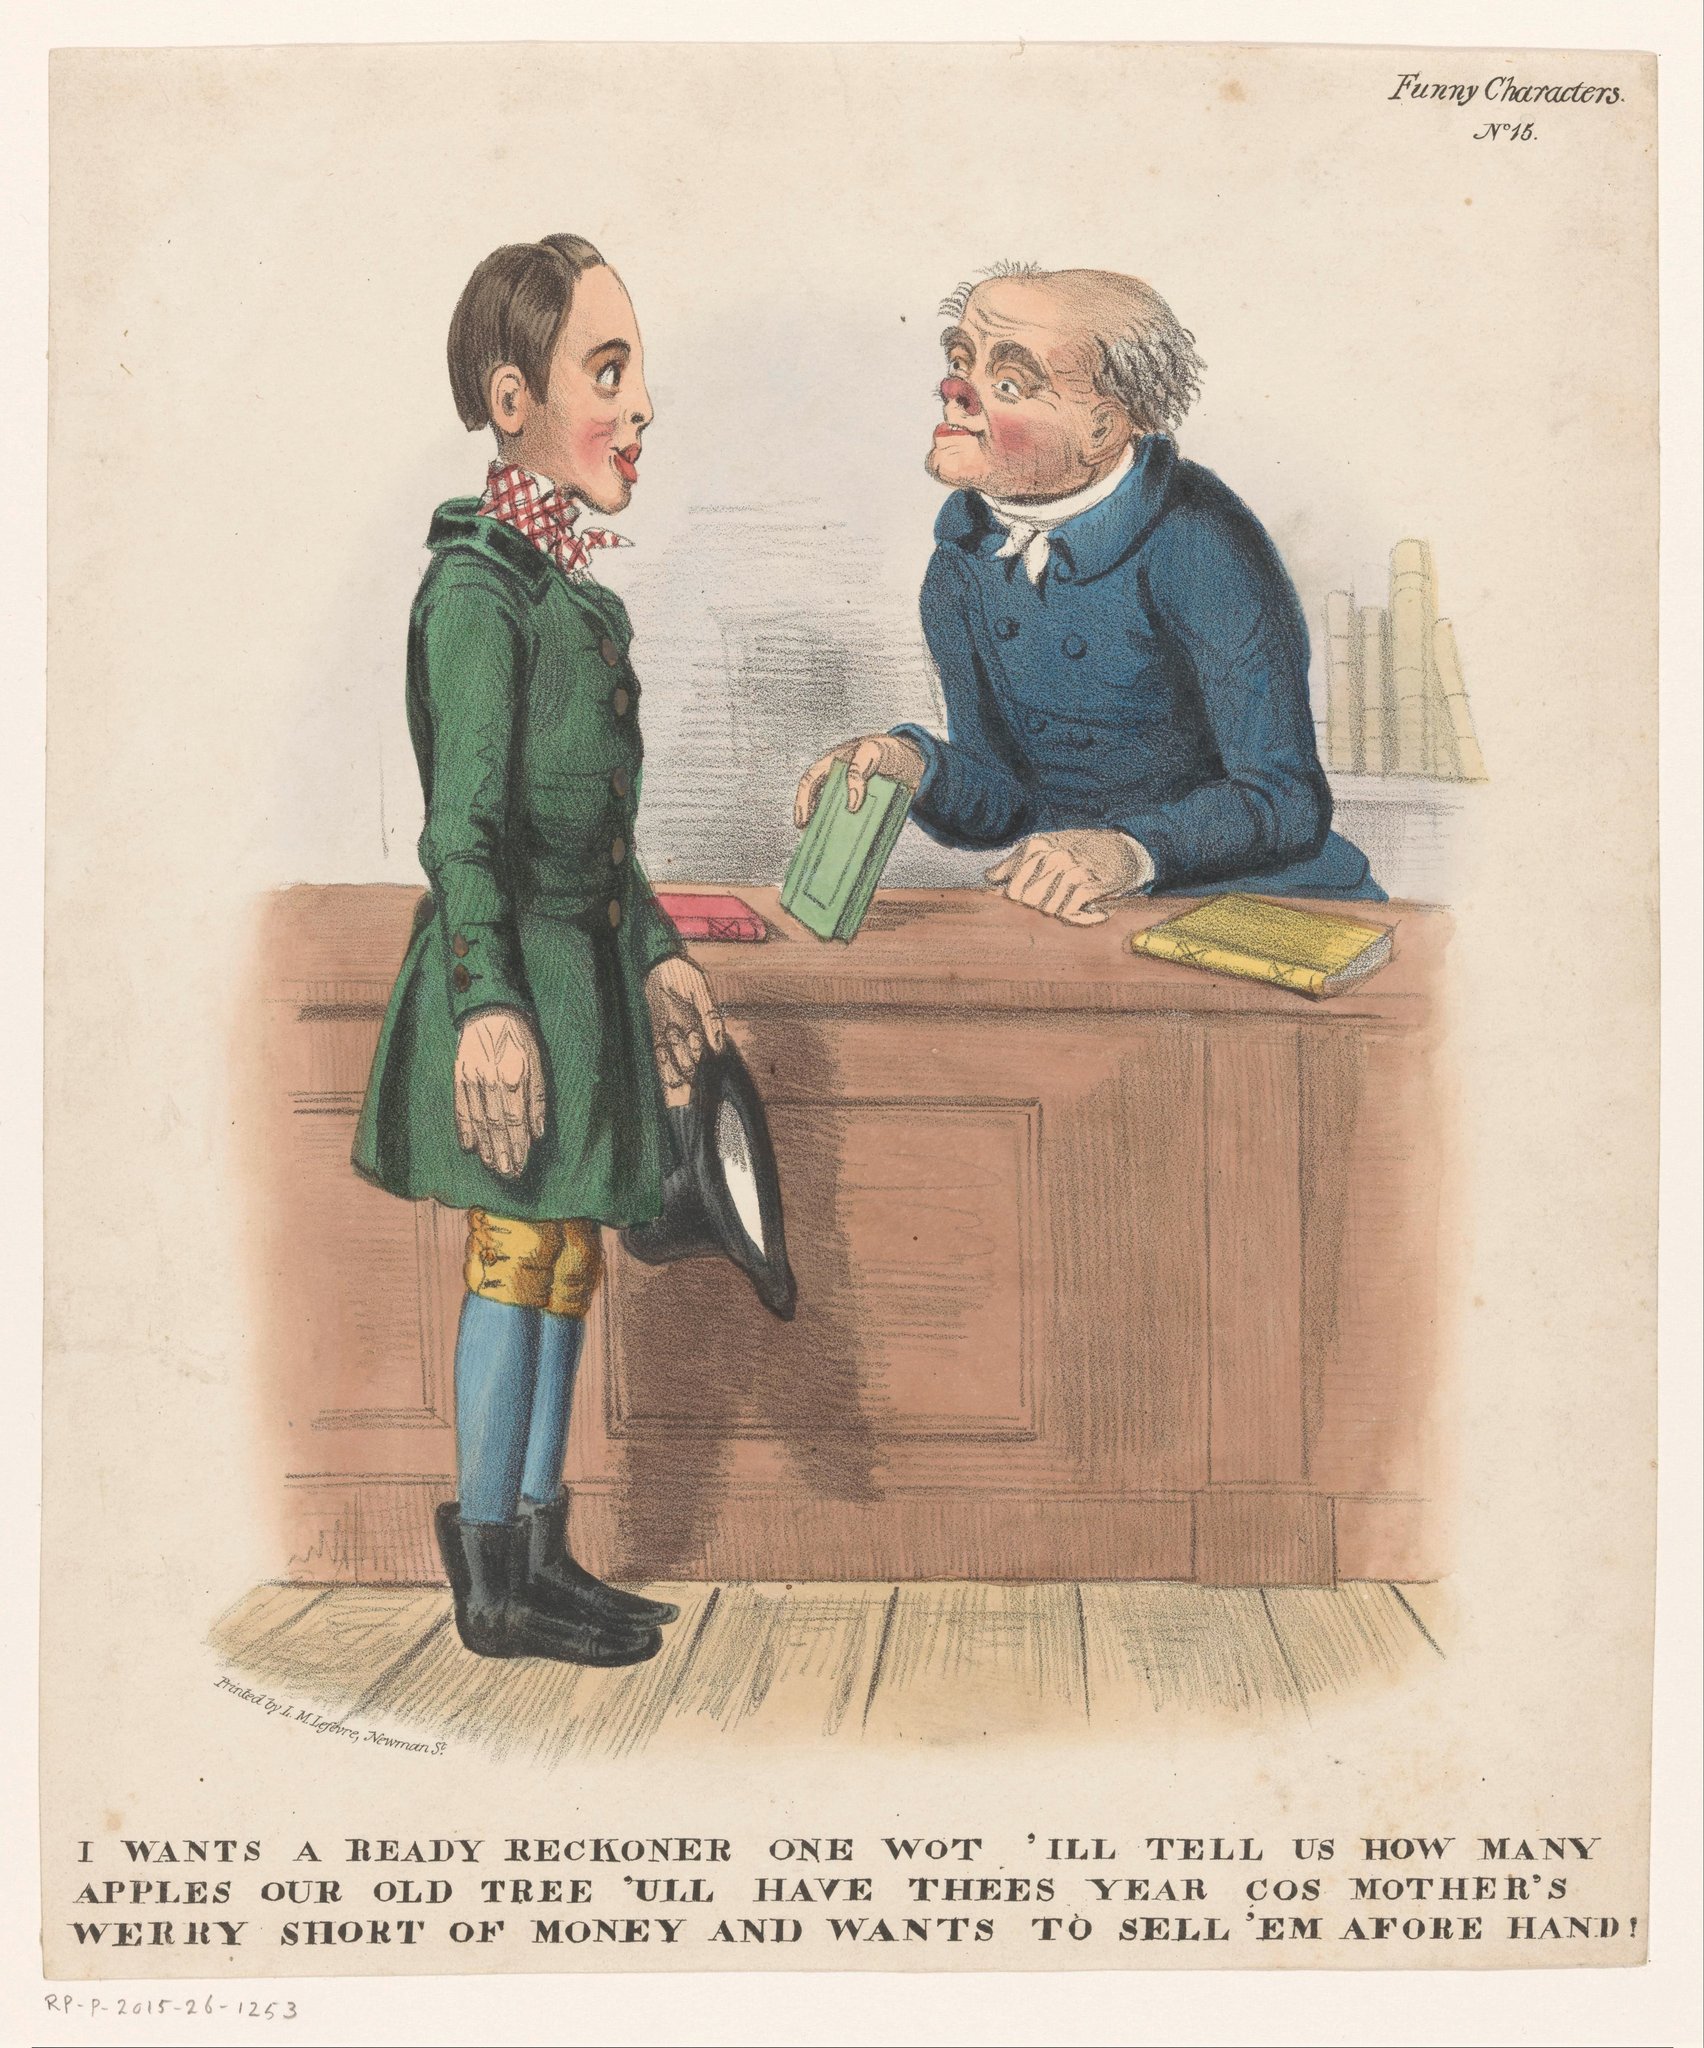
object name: print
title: Jongeman voor de toonbank van een boekhandel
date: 1832-1838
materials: paper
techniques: hand coloring, lithograph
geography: london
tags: book-shop, bookseller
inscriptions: collector's mark: Lugt 2228, collector's mark: Lugt 4779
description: De jongeman vraagt in plat Engels om een boek dat de appeloogst van het aankomende jaar kan voorspellen.